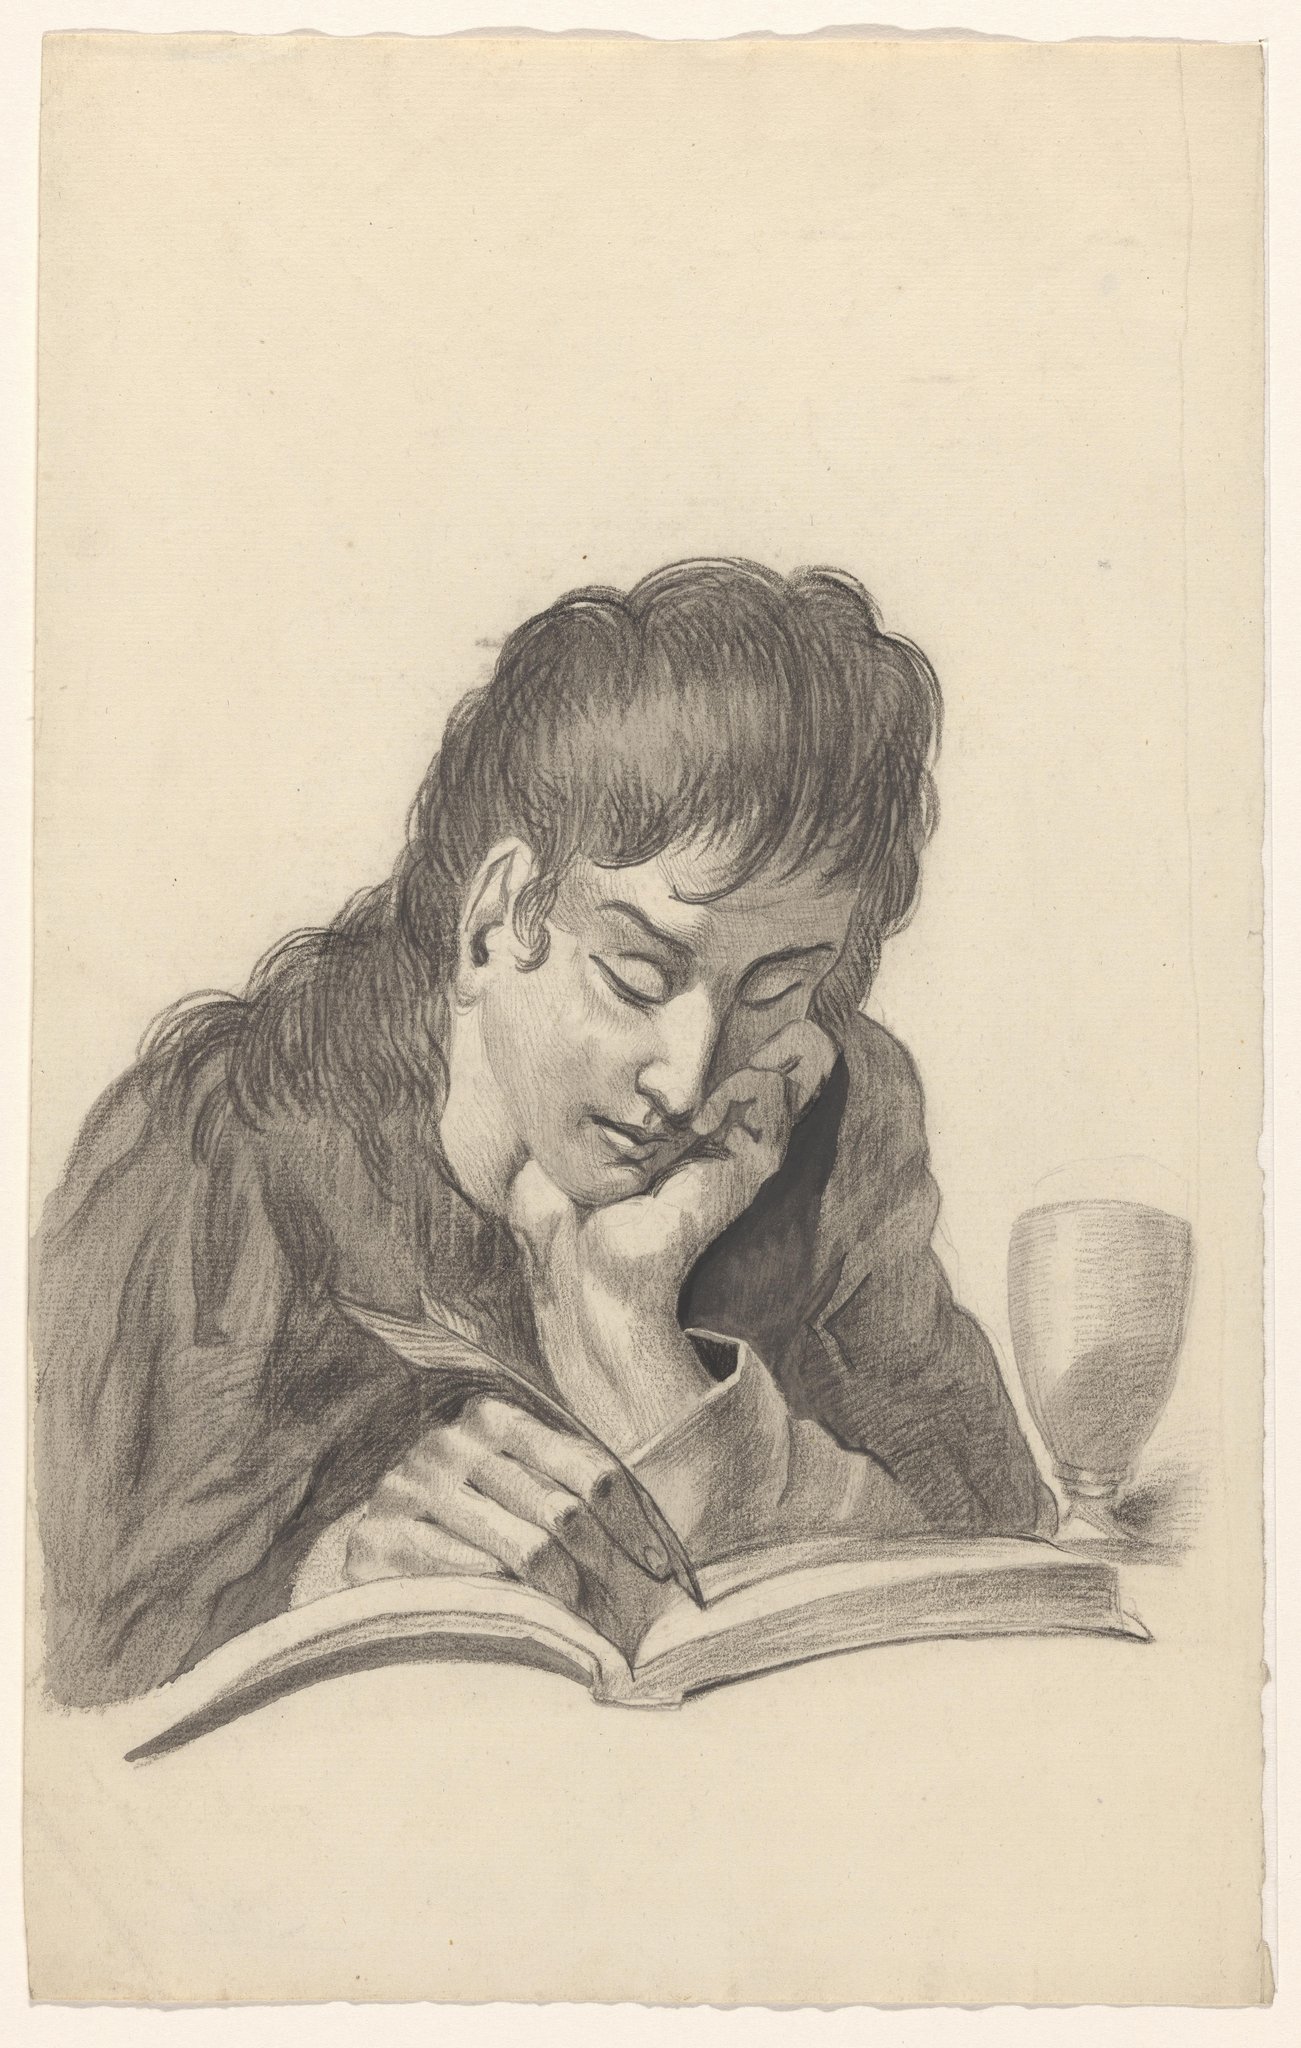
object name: drawing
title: Evangelist Johannes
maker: joannes carolus alberdingk thijm (jan)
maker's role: pater, schrijver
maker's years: 1847-1926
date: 1853-1860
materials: chalk, paper, pencil, watercolor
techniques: brush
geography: netherlands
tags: st. john the evangelist writing the gospel, usually the eagle present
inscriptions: inscription: ‘A.Th.’